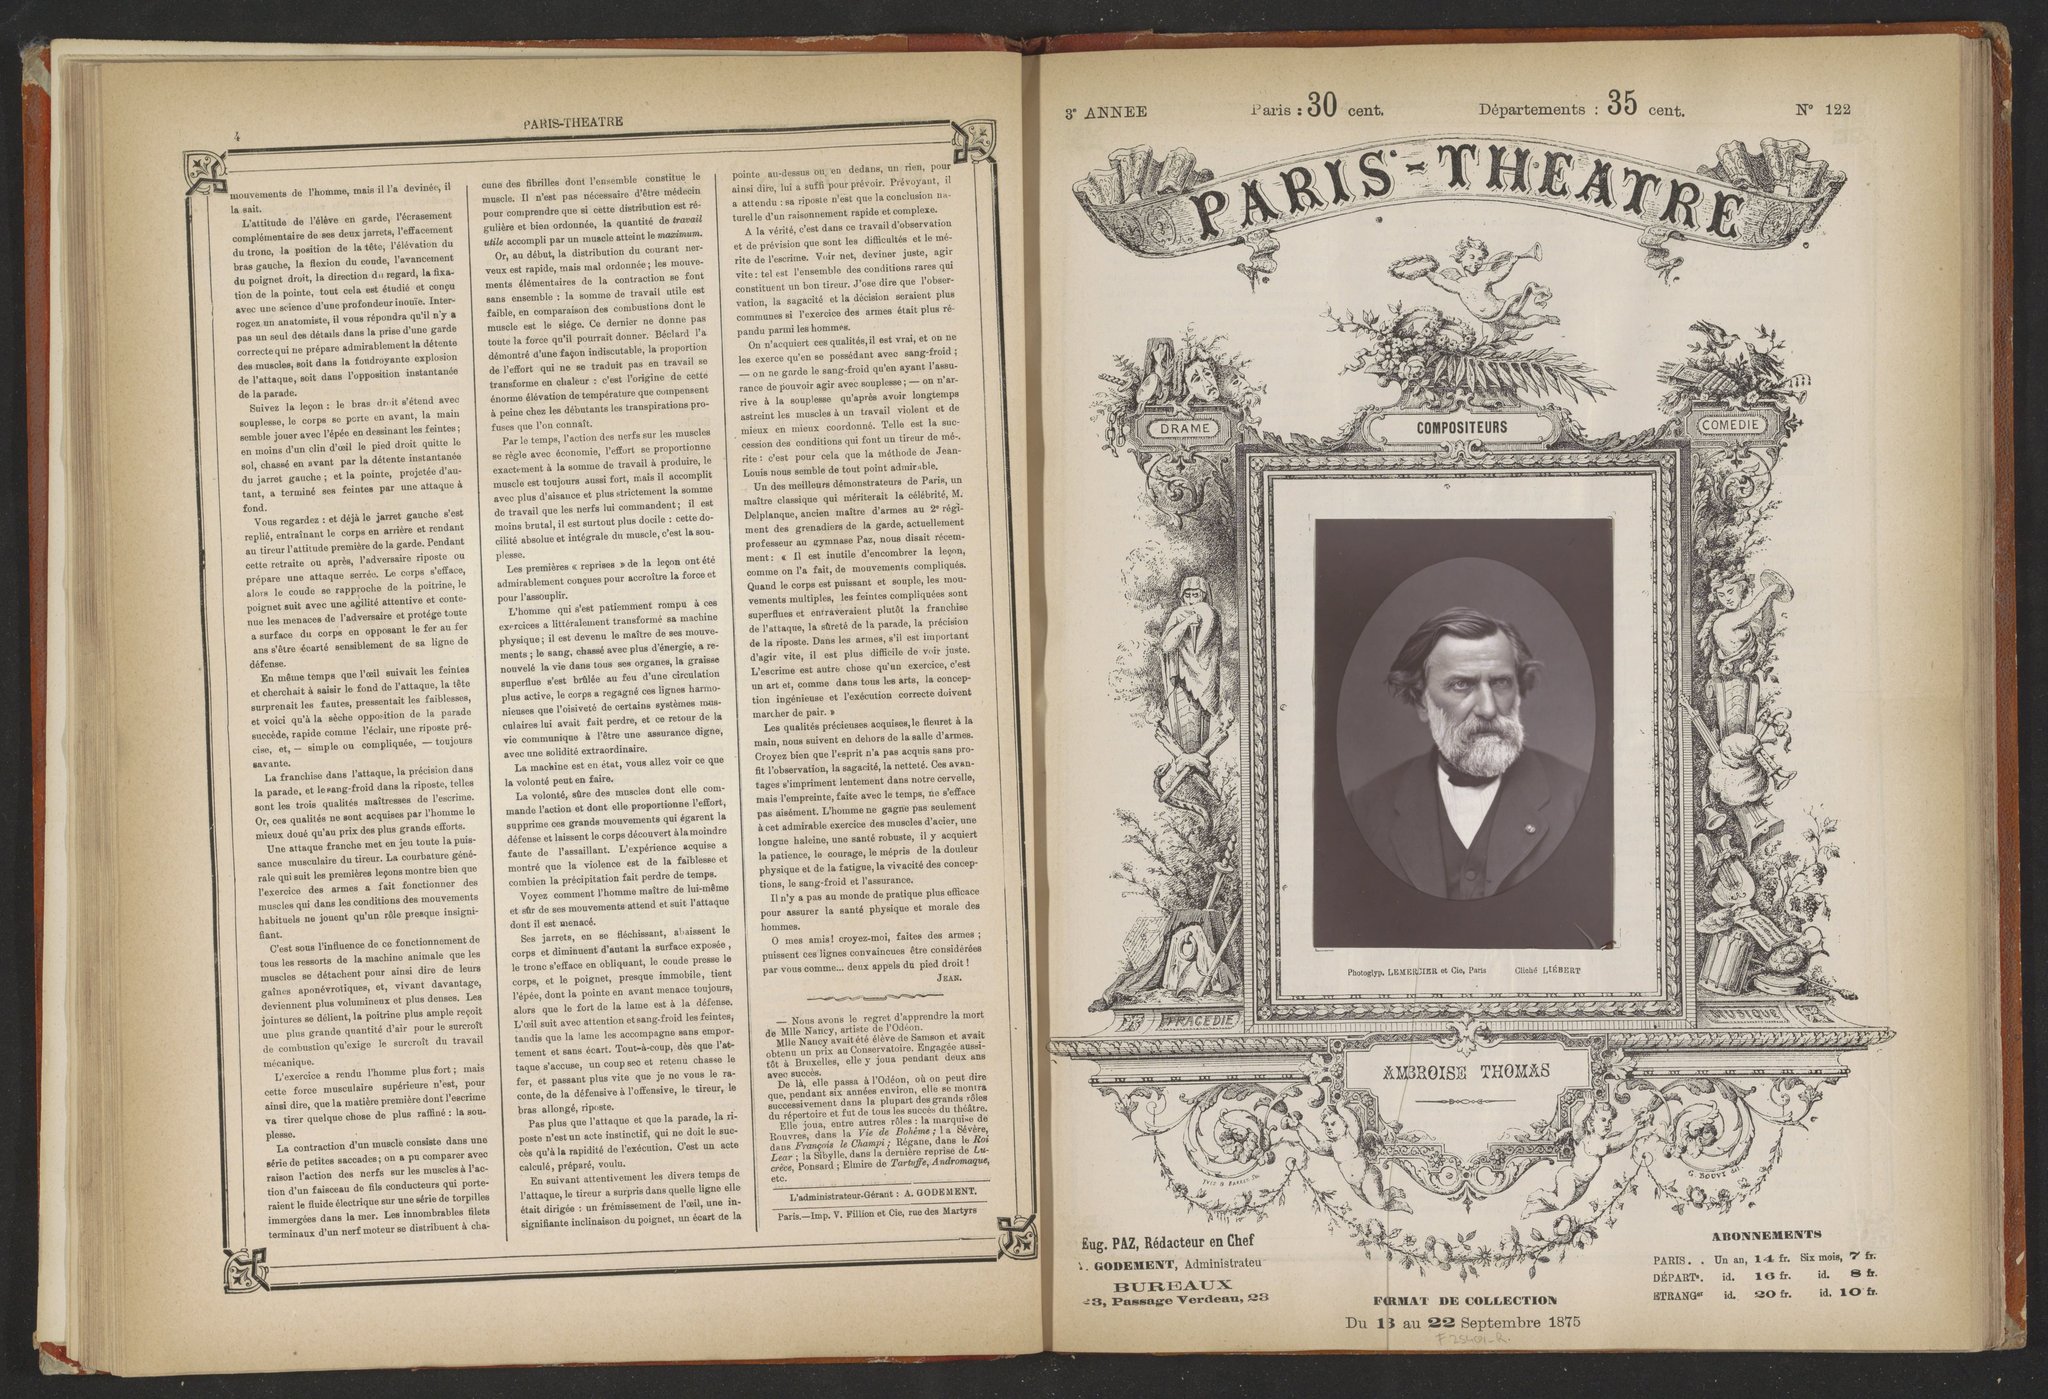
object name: photomechanical print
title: Ambroise Thomas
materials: paper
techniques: woodburytype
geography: france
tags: ambroise thomas, composer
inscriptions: inscription: ‘Du 16 au 22 Septembre 1875’, number: ‘No 122’